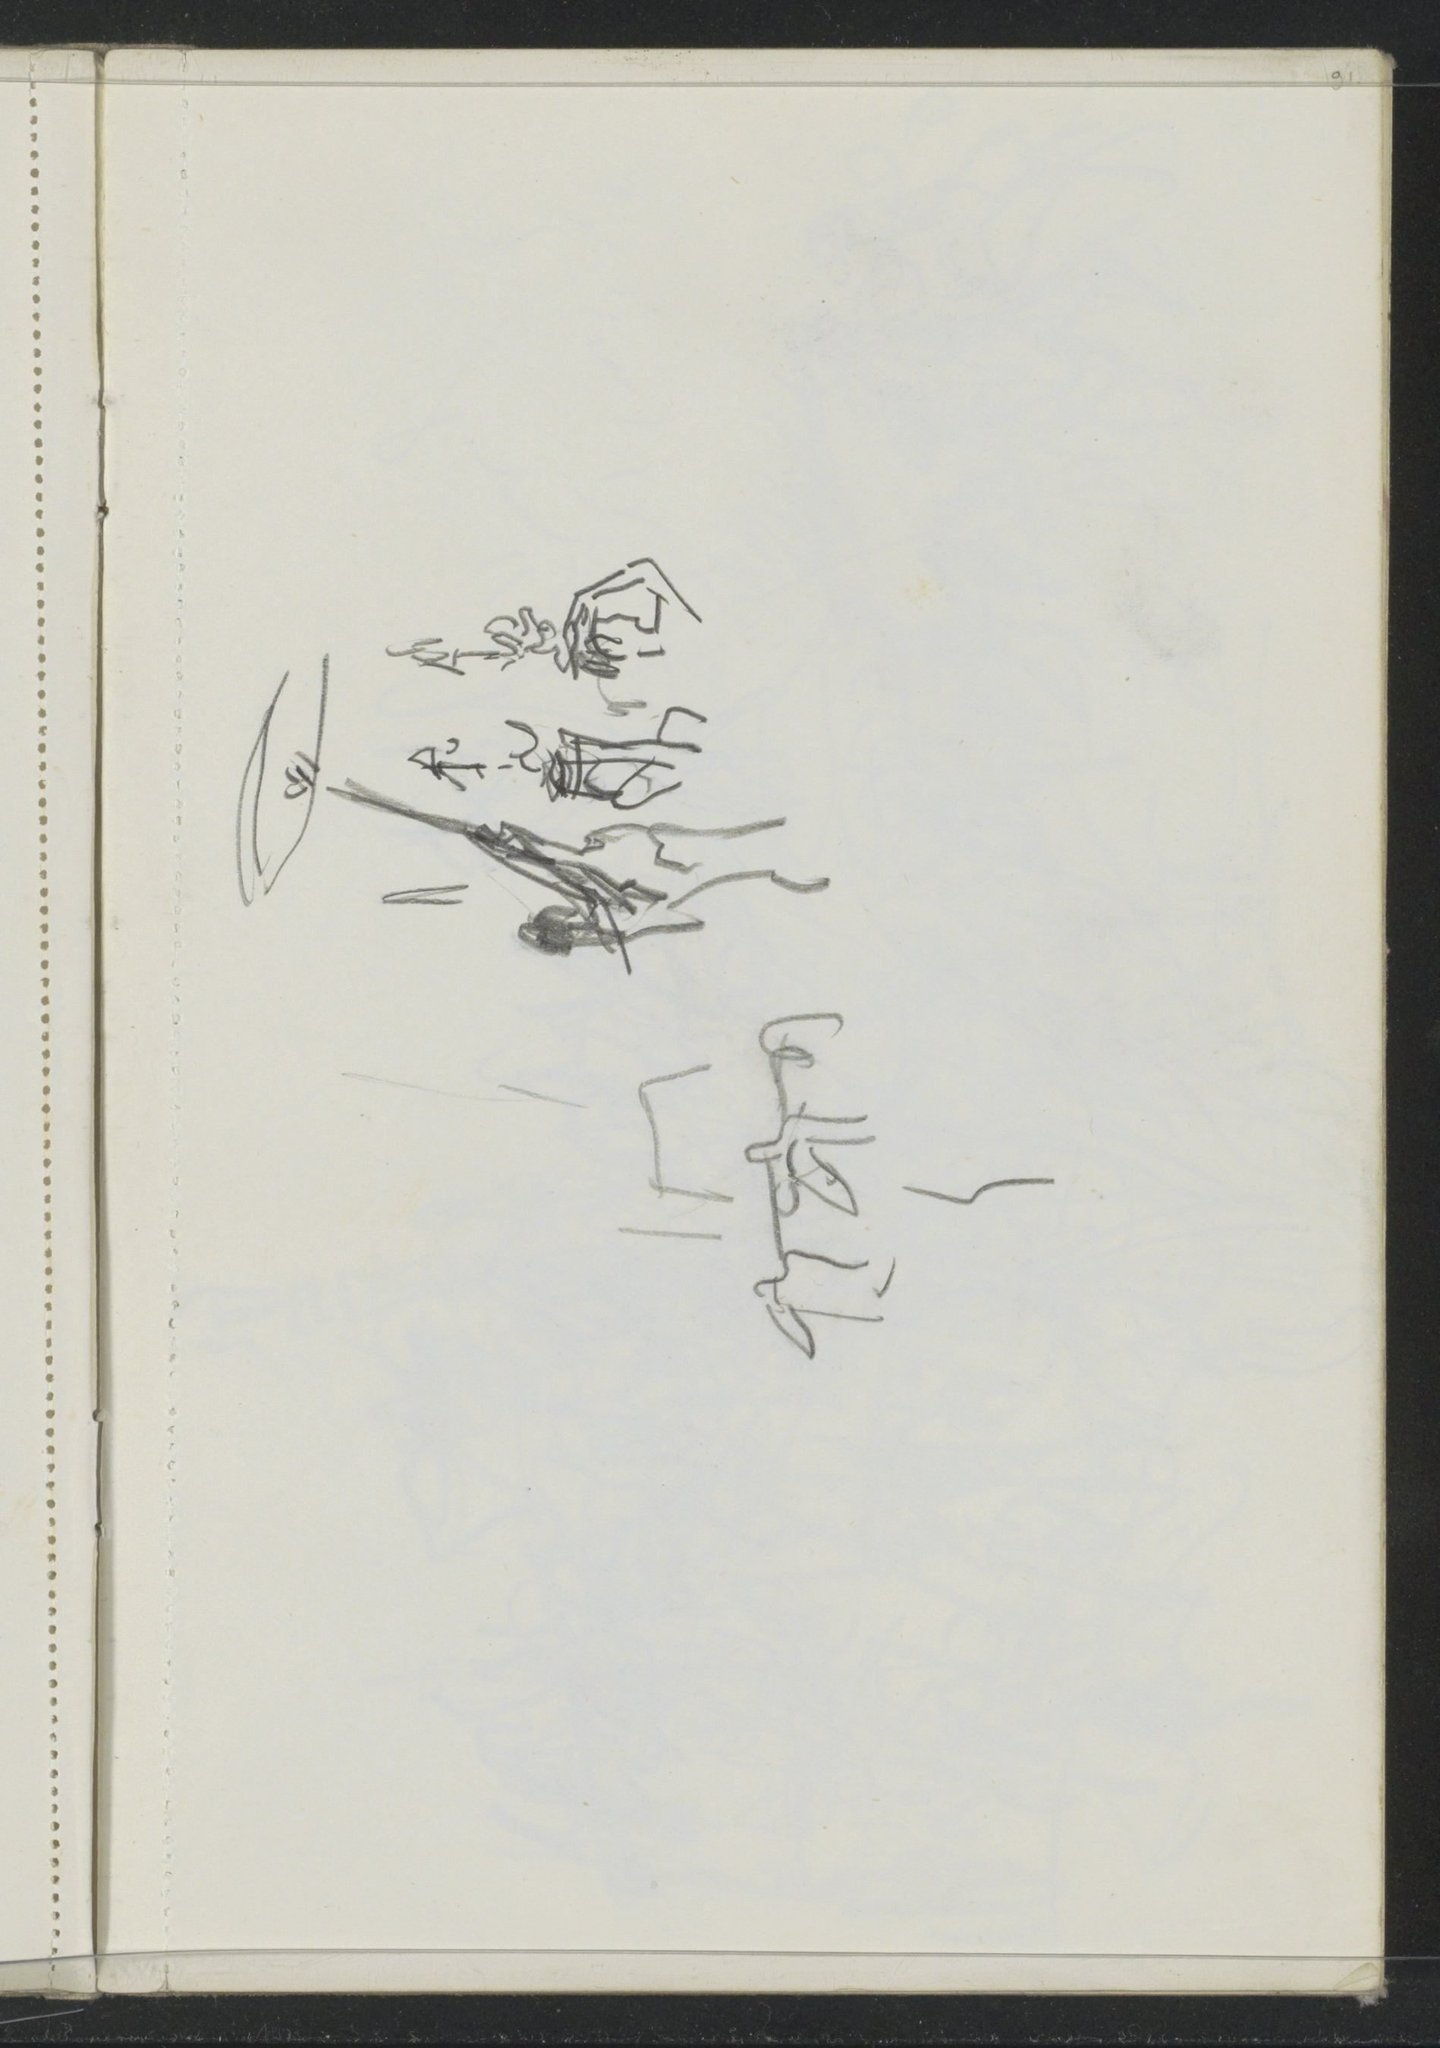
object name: sketchbook leaf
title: Figuur met een parasol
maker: marius bauer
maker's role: draughtsman, print maker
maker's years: 1867-1932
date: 1925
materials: paper, pencil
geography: indonesia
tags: standing figure, parasol, sunshade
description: Vermoedelijk maakt de figuur deel uit van een optocht. Pagina 91 uit een schetsboek met 74 bladen.